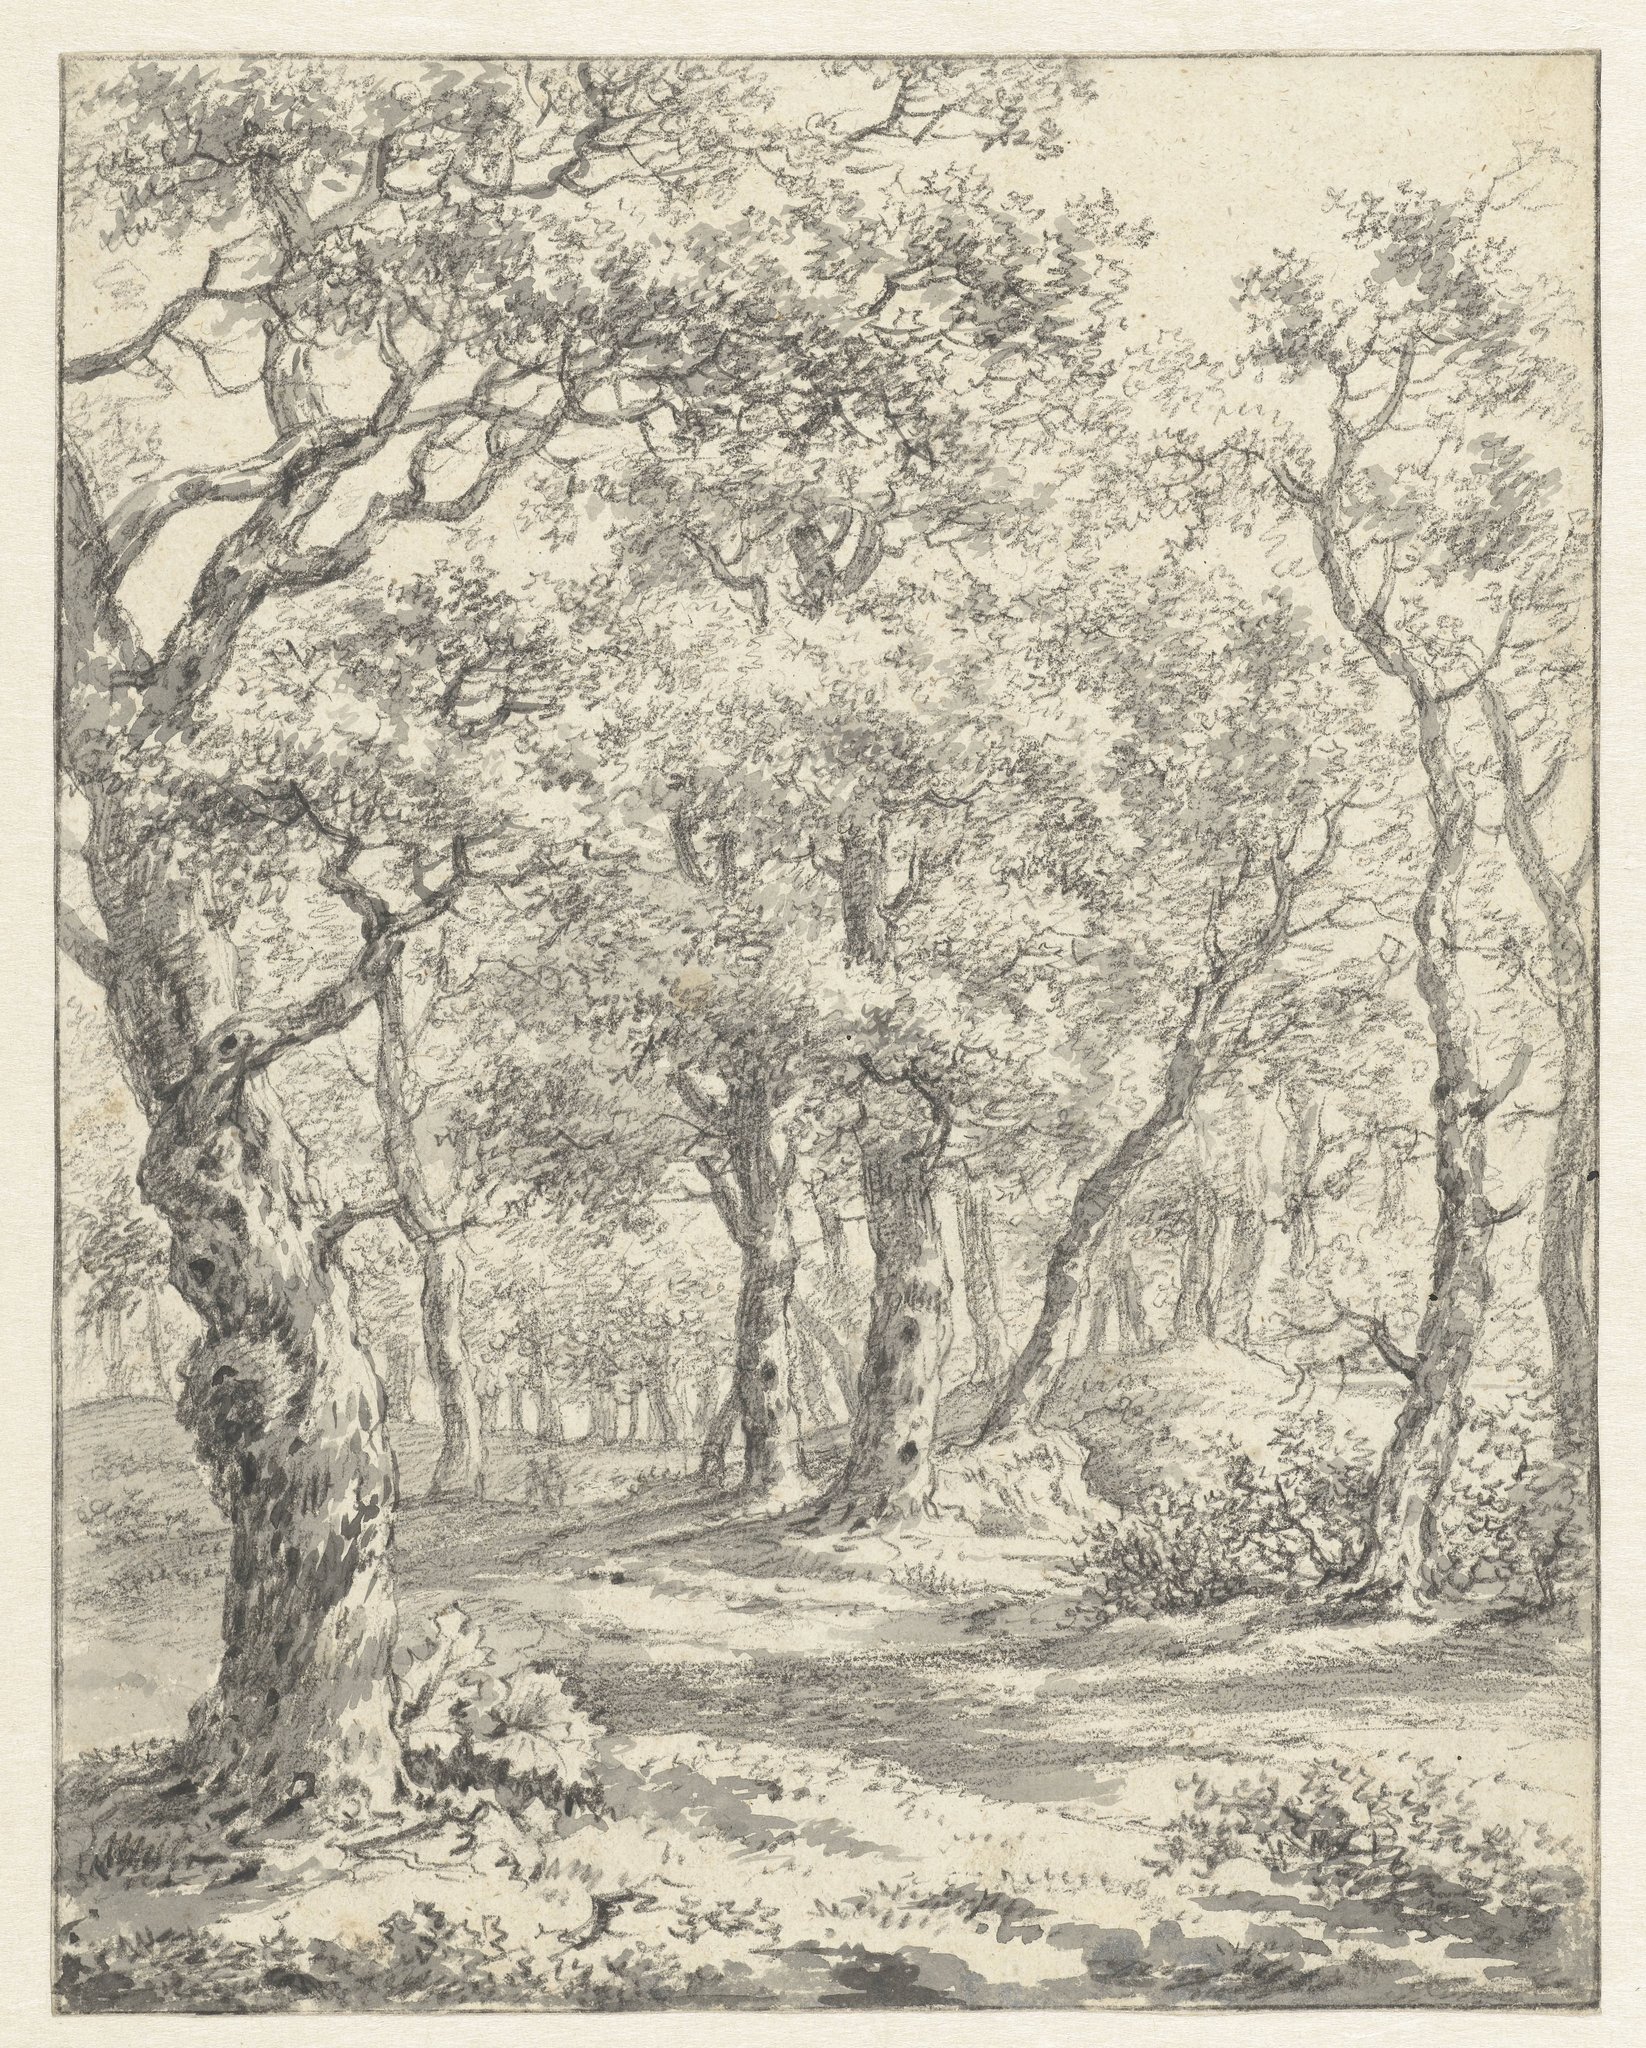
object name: drawing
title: Boslandschap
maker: couwenhoven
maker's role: draughtsman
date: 1818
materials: chalk, paper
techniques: brush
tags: forest, wood